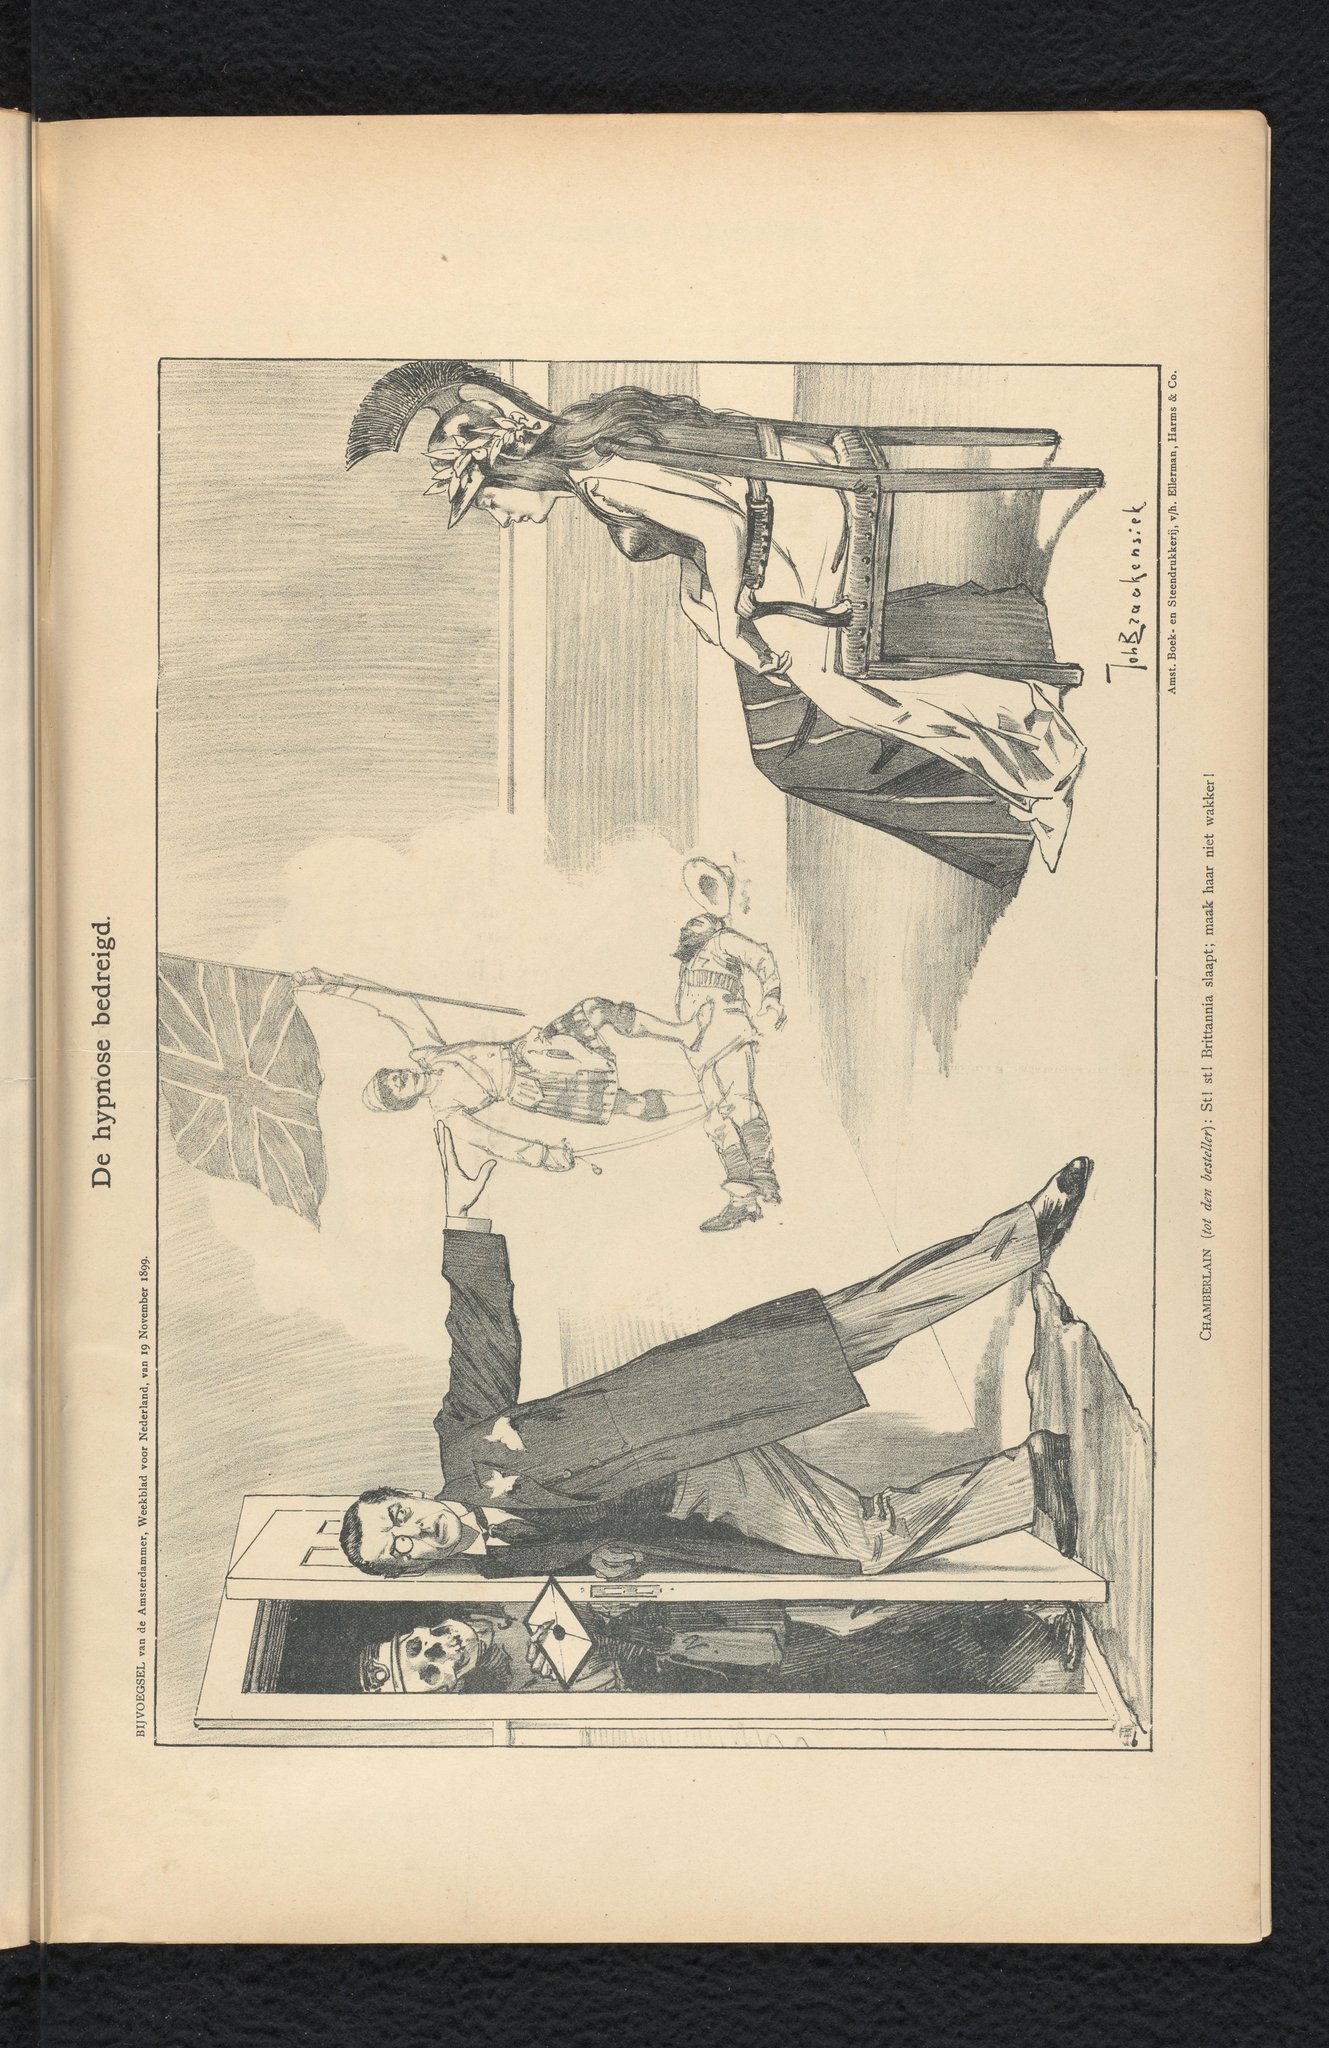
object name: cartoon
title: De hypnose bedreigd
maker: johan braakensiek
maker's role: draughtsman, print maker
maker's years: 1858-1940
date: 1899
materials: paper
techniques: lithograph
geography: amsterdam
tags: announcement of death, personifications of countries, nations, states, districts, etc., death as skeleton, hypnosis and suggestion, postman, political caricatures and satires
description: Brittannia slaapt in een stoel, onder hypnose gebracht door Joseph Chamberlain ziet zij alleen het droombeeld van een overwinnende Britse militair staande op het lichaam van een Boer. Chamberlain houdt aan de deur de Dood die als postbode een envelop met zwarte rouwranden wil afgeven.